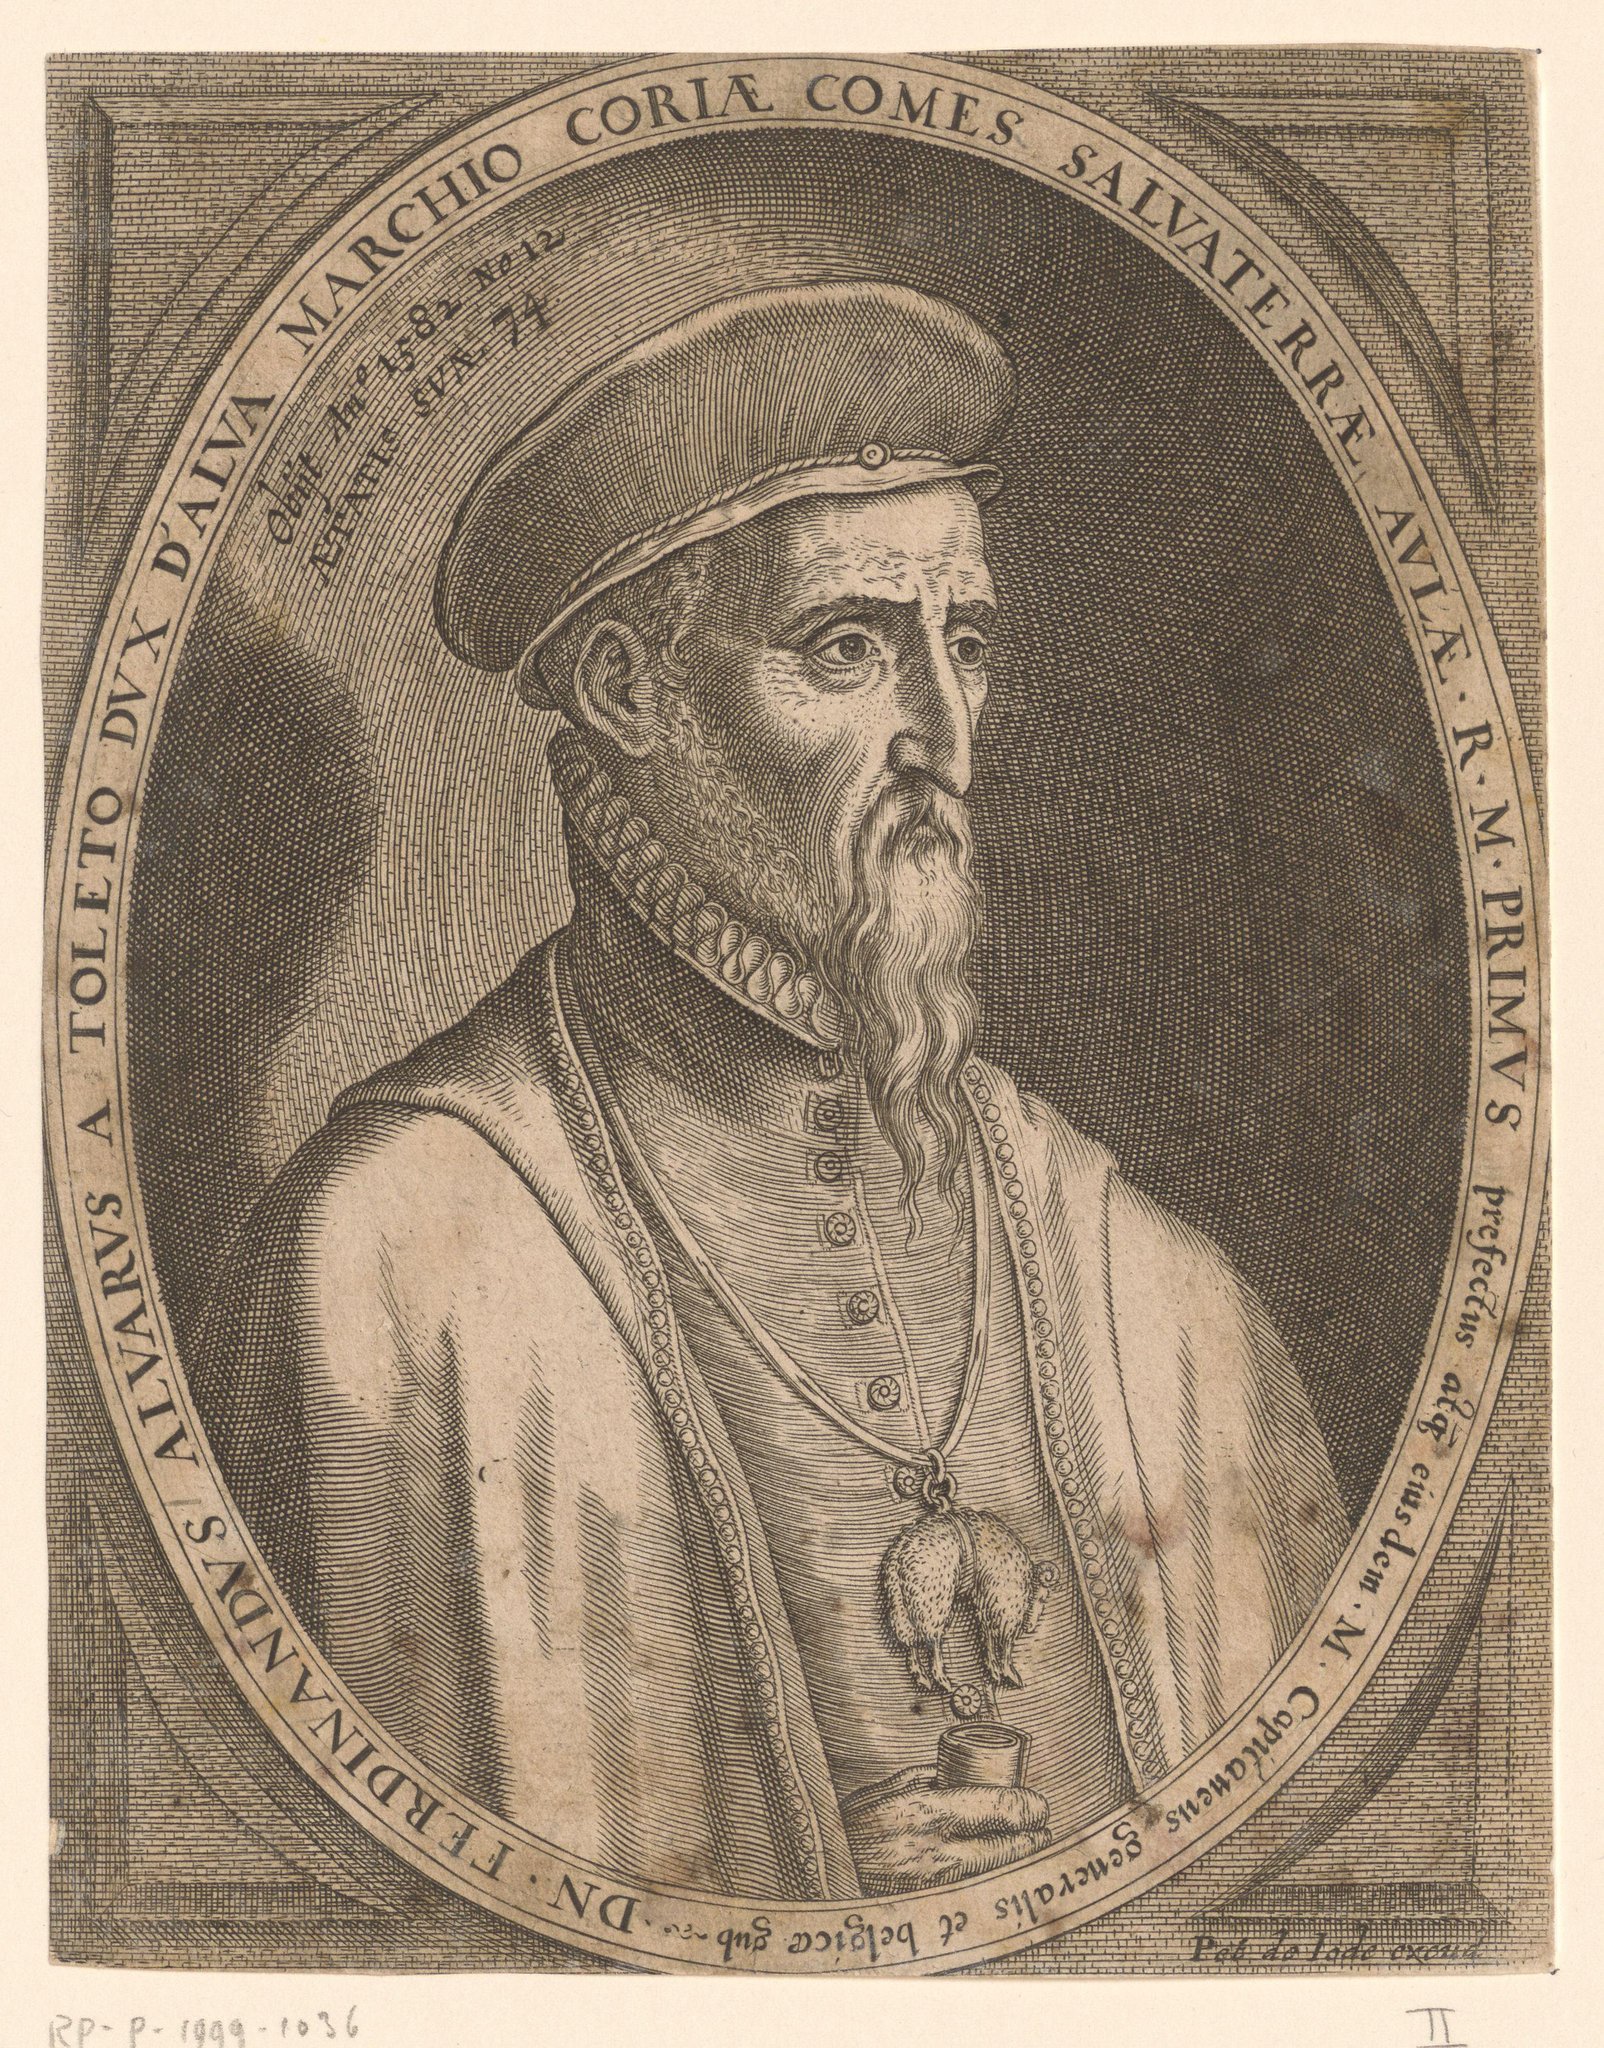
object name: book illustration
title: Portret van Ferdinandus Alvarus van Toledo, hertog van Alva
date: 1651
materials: paper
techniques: engraving, etching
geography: antwerp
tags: fernando álvarez de toledo (3rd duke of alba), historical persons, knighthood order of the golden fleece - insignia of a knighthood order, e.g.: badge, chain (with name of order)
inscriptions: collector's mark: Lugt 2760, collector's mark: Lugt 2228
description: Prent uit: Theatrum pontificum, imperatorum, regum, ducum, pricipum, etc. Antwerpen: Peter de Jode, 1651.